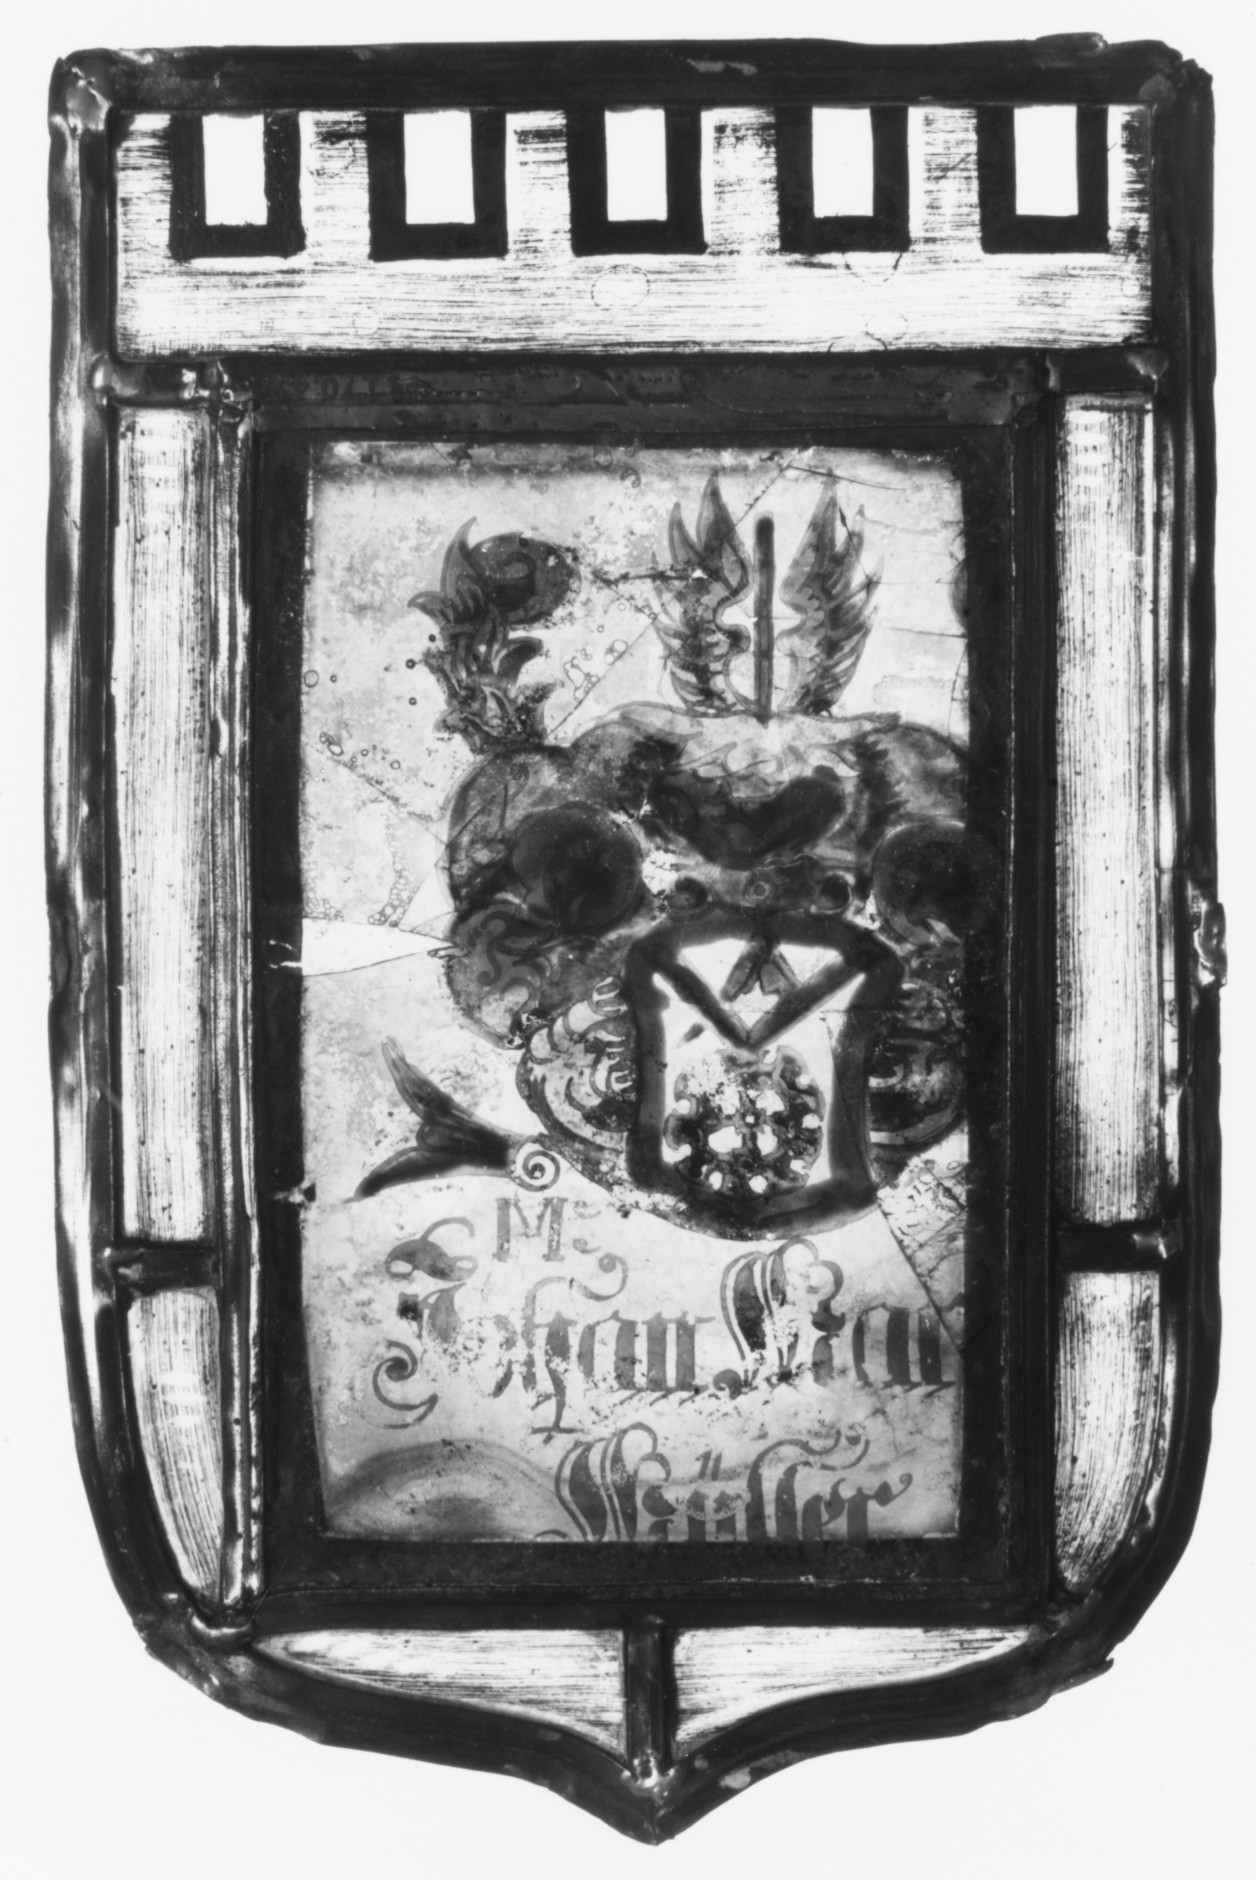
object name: armorial panel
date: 1601-1800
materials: glass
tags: coat of arms